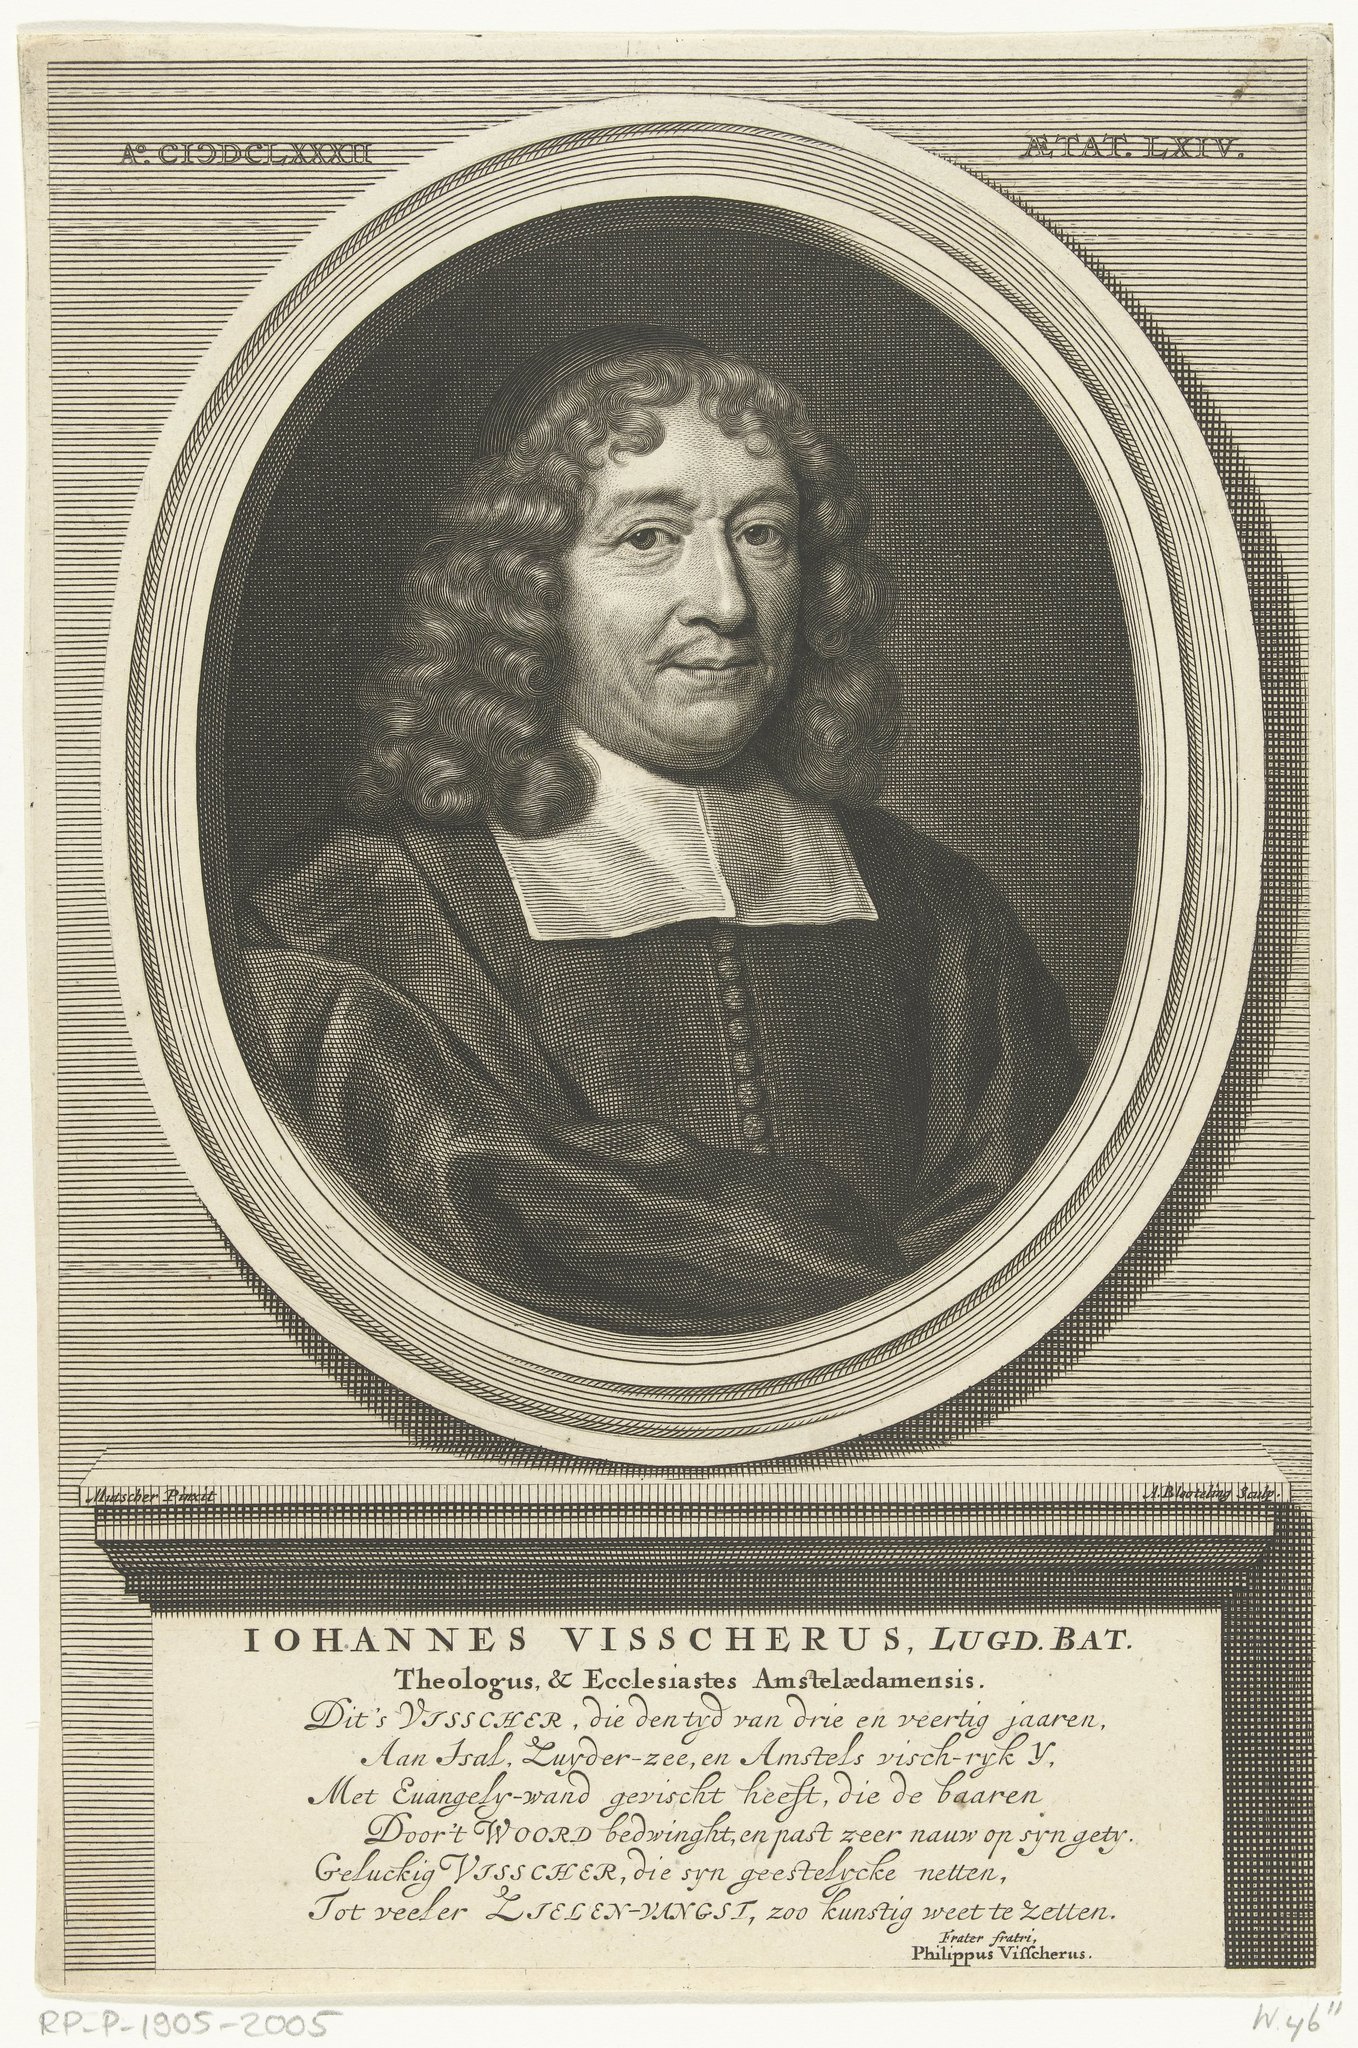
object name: print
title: Portret van Johannes Visscher op 64-jarige leeftijd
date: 1682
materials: paper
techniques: engraving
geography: amsterdam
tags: amsterdam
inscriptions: collector's mark: Lugt 2228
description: Borstbeeld van de Amsterdamse predikant Johannes Visscher. Onder het portret een vers over Visscher in het Nederlands.